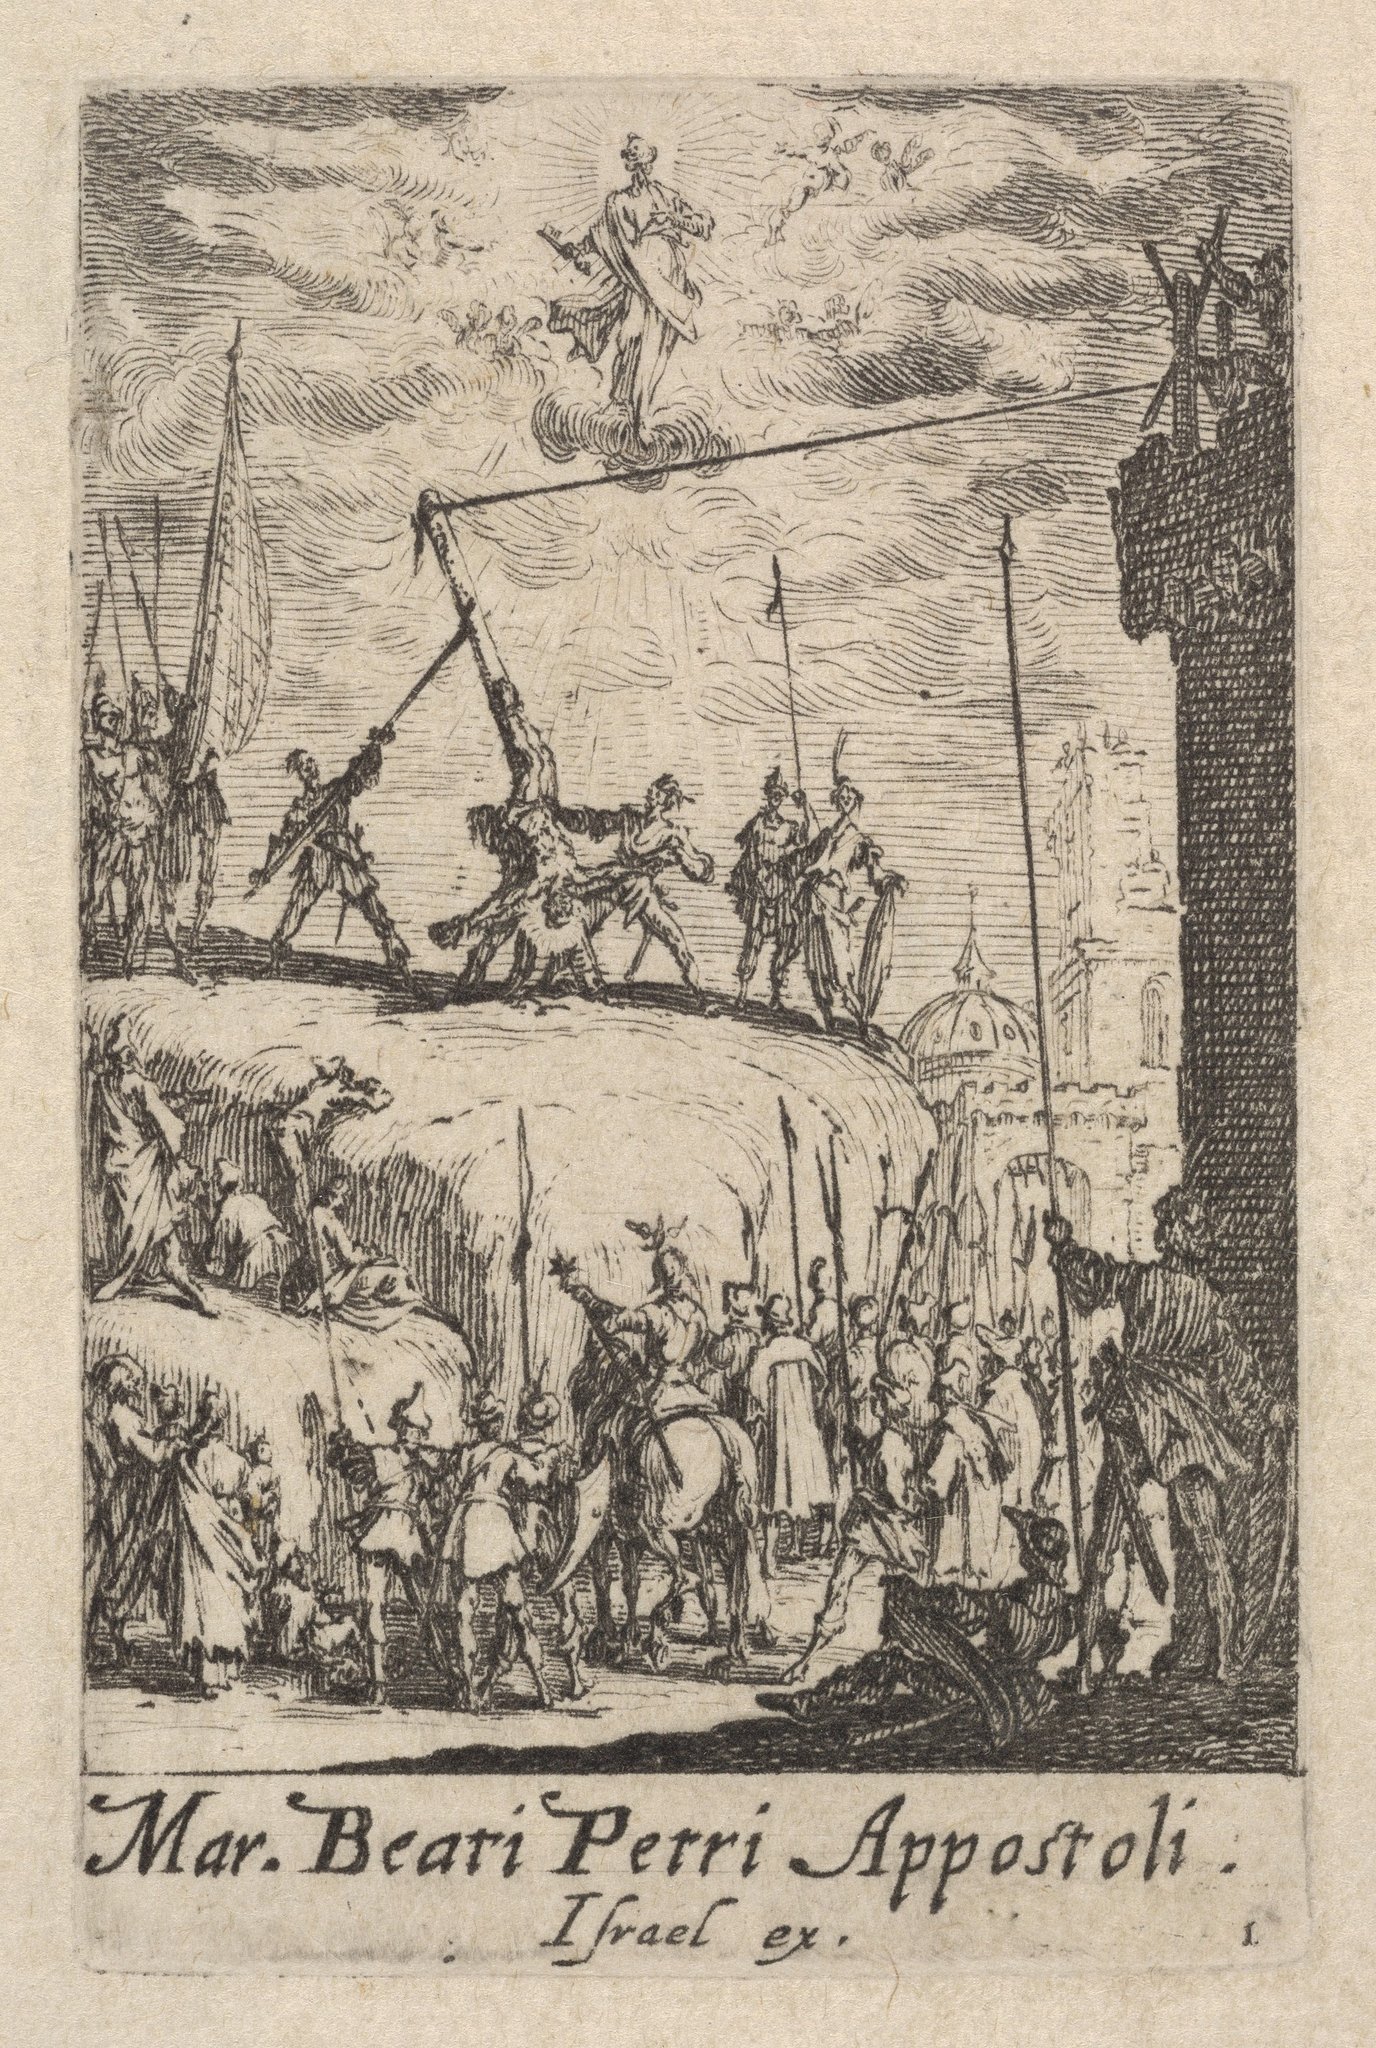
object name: print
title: Martyrdom of Saint Peter, from "The Little Apostles" (Les Petits Apôtres)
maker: jacques callot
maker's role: artist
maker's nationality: french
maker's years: 1592-1635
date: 1632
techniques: etching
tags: soldiers,suffering,angels,saint peter